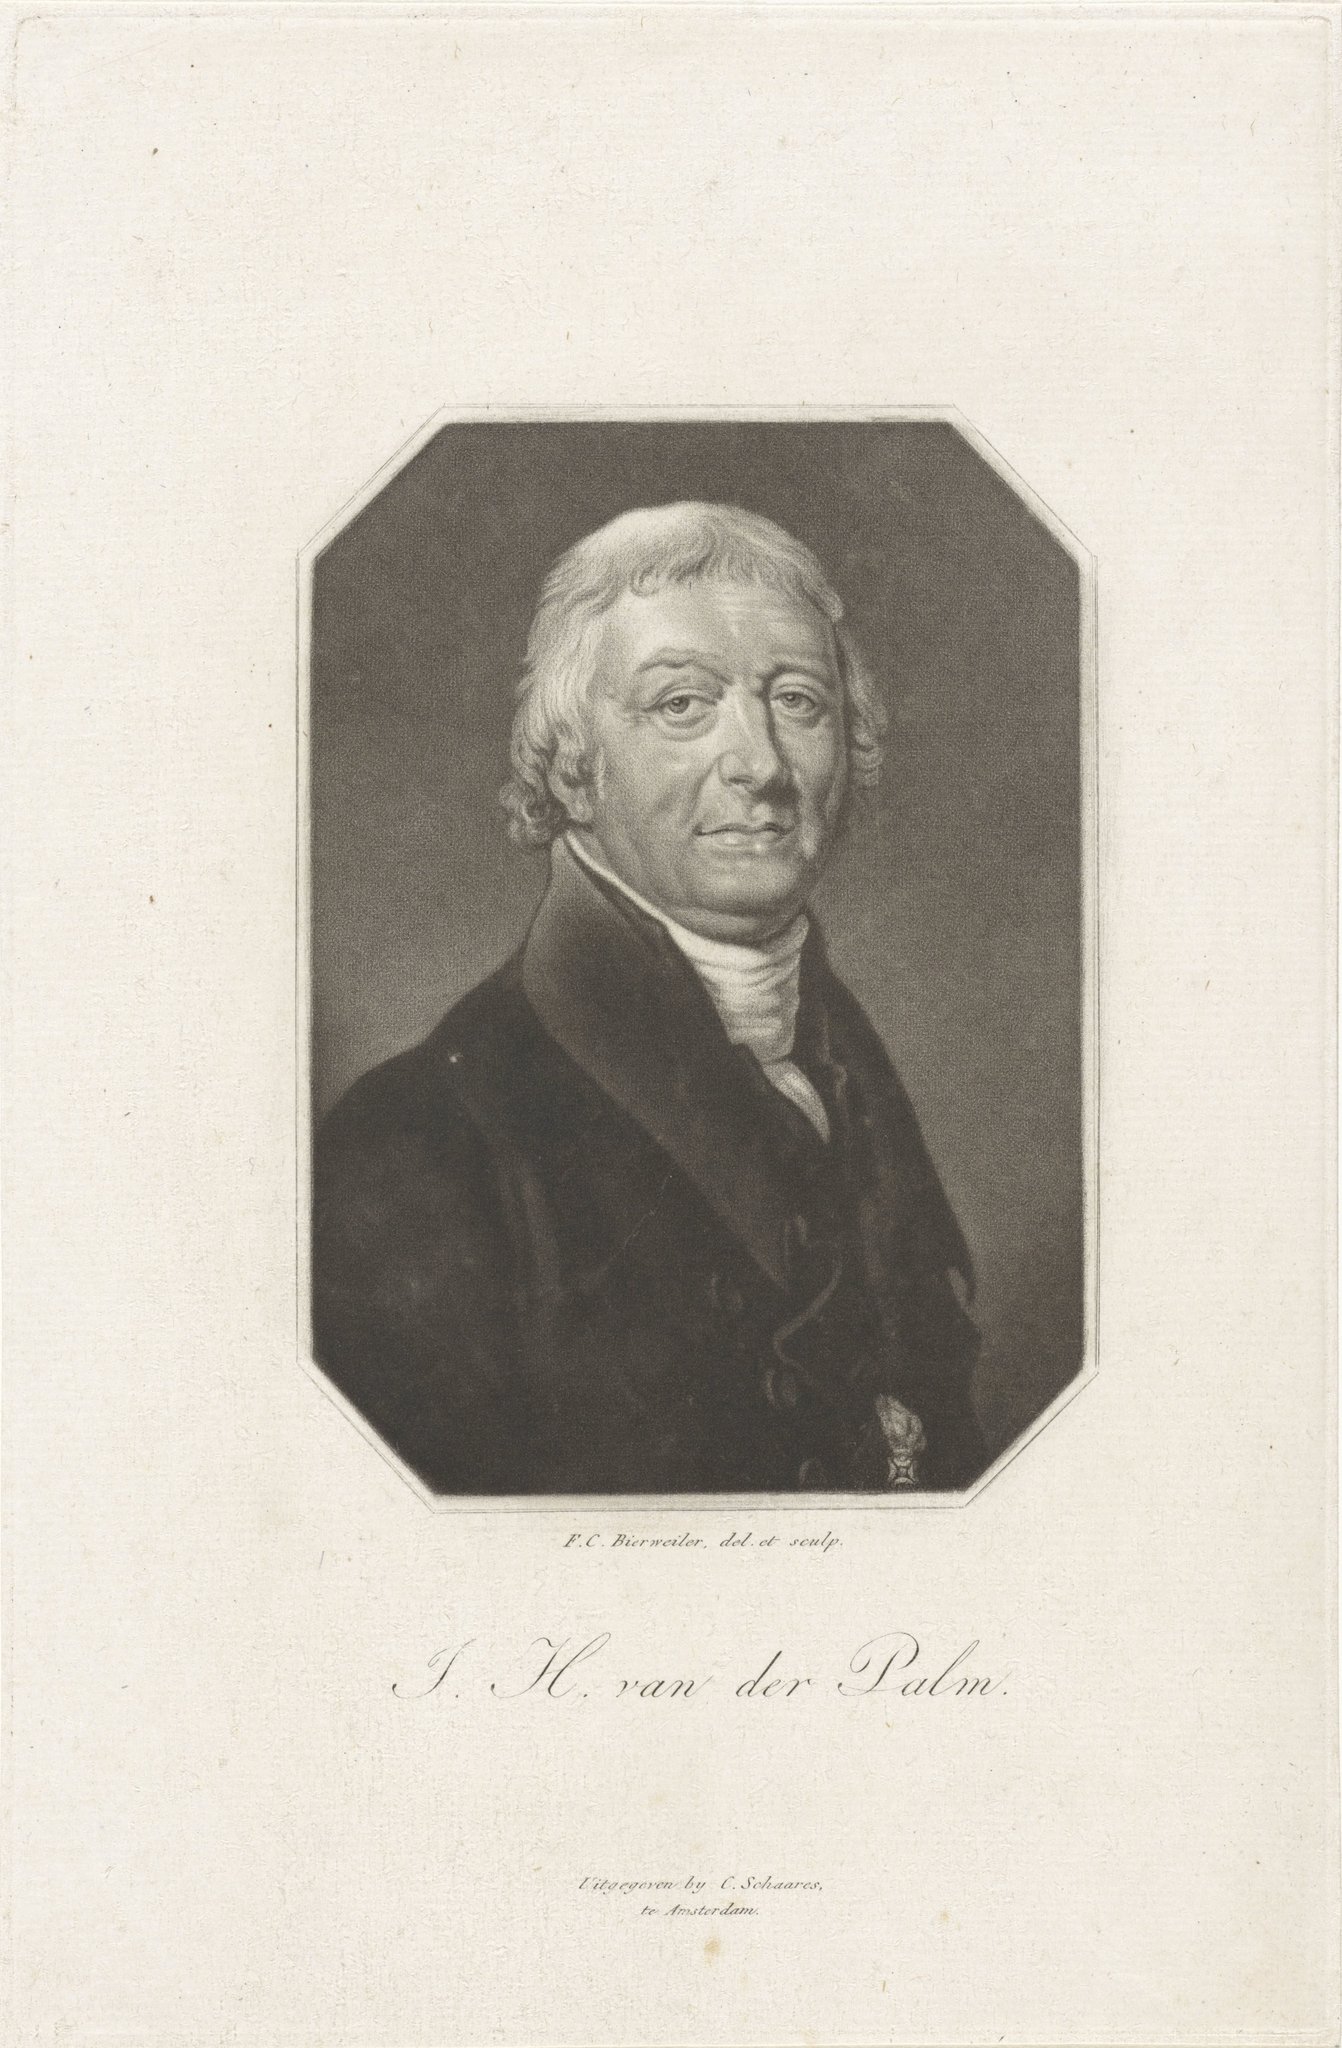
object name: print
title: Portret van Johannes Hendricus van der Palm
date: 1826-1830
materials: paper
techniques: engraving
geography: amsterdam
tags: rotterdam, johannes hendricus van der palm, historical persons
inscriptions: collector's mark: Lugt 2228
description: Johannes Hendricus van der Palm, predikant, theoloog en hoogleraar oosterse talen te Leiden. Op het revers een ridderorde.